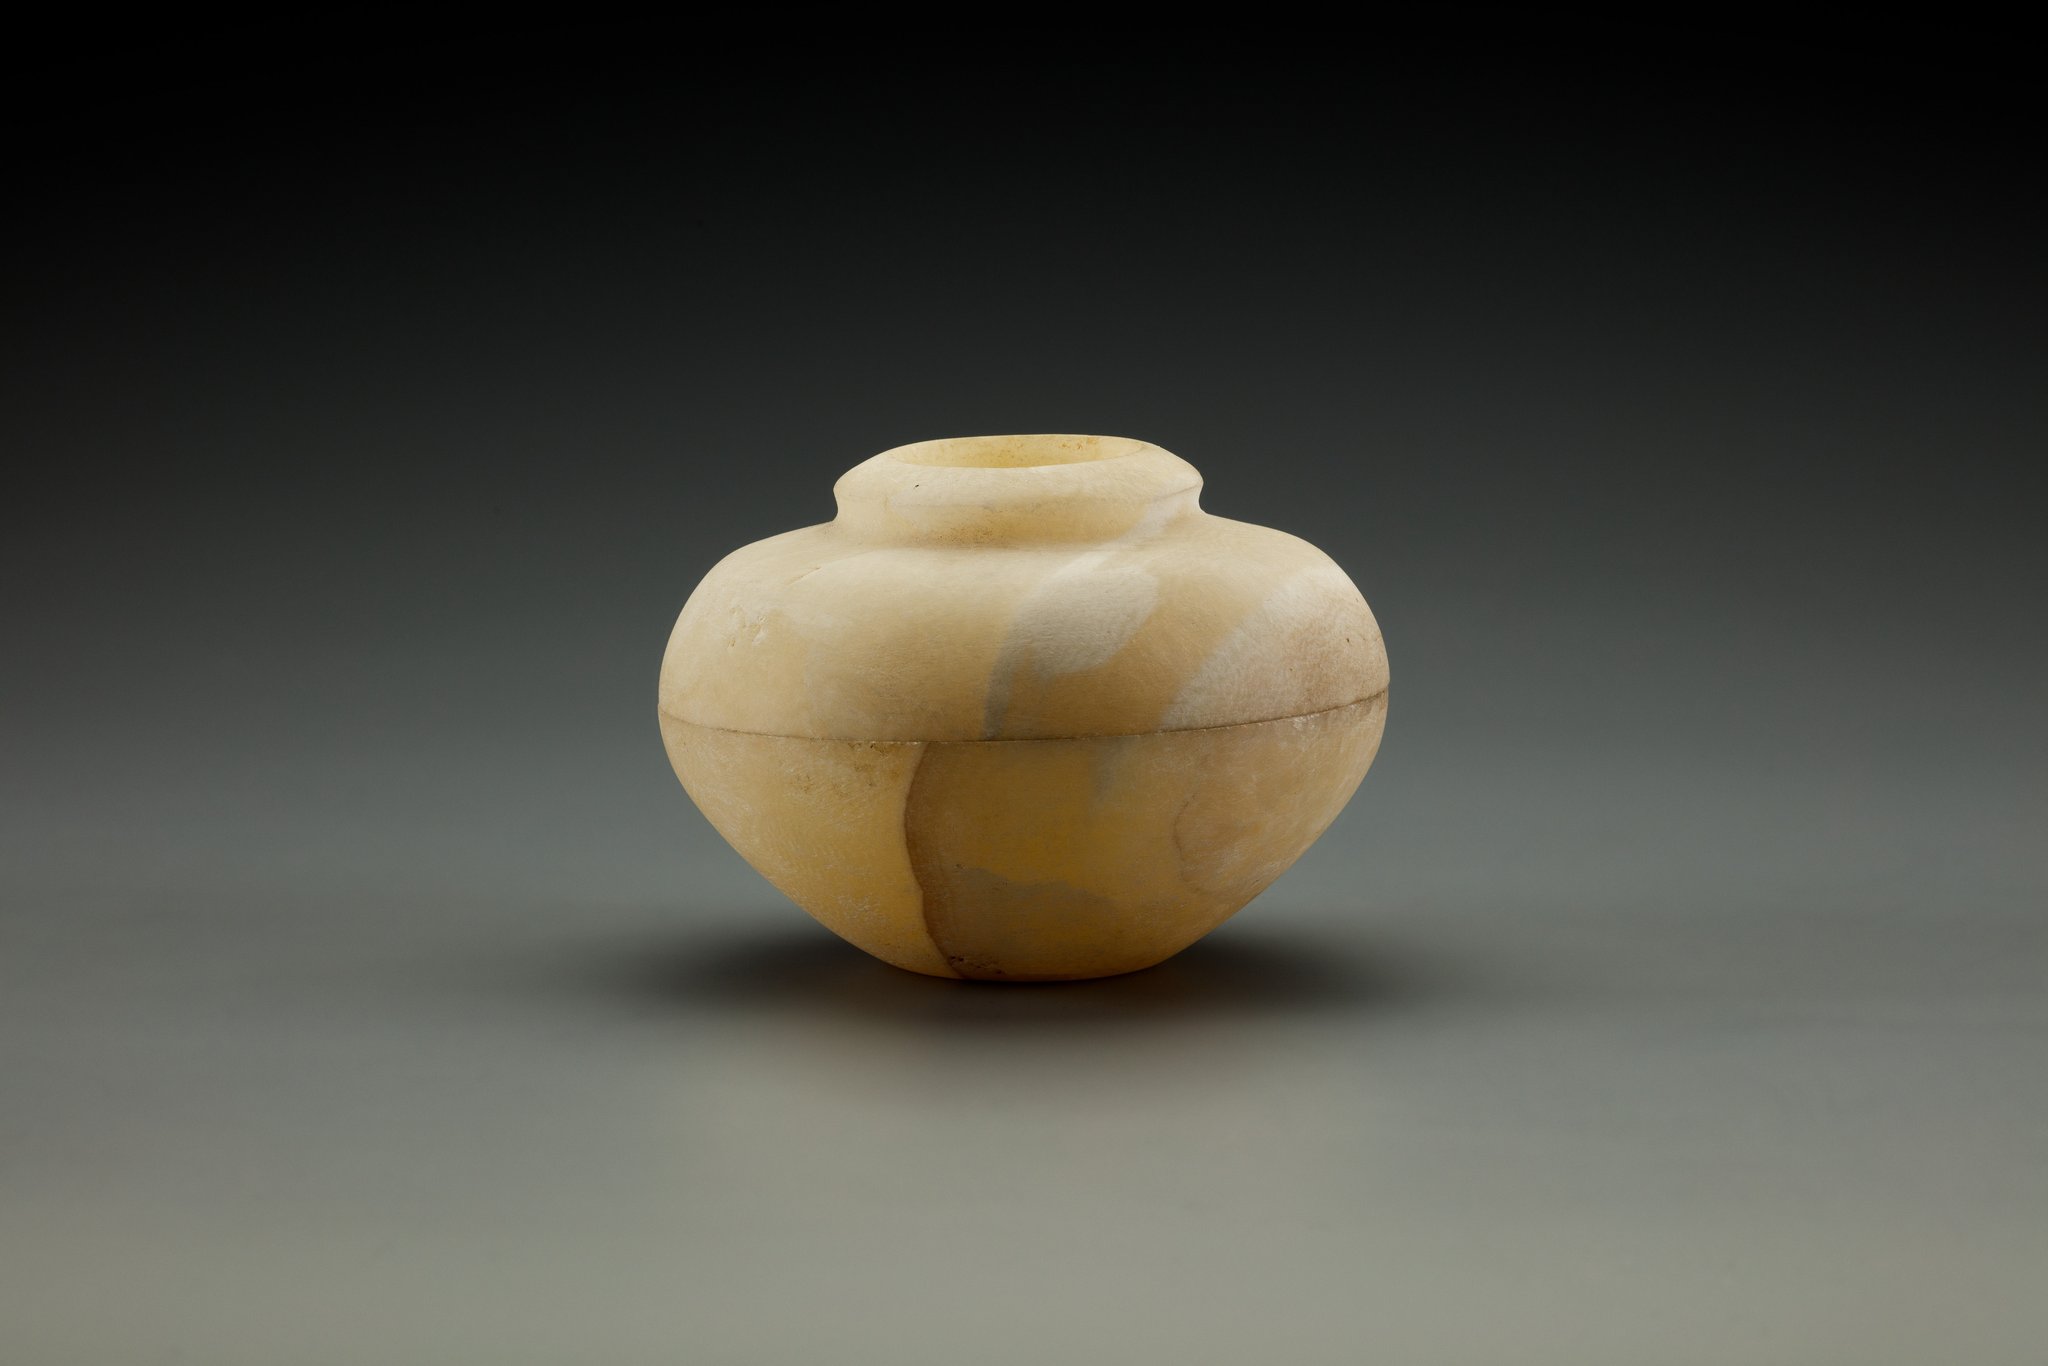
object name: bowl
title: Small bowl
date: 2750-2649 BCE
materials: stone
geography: egypt